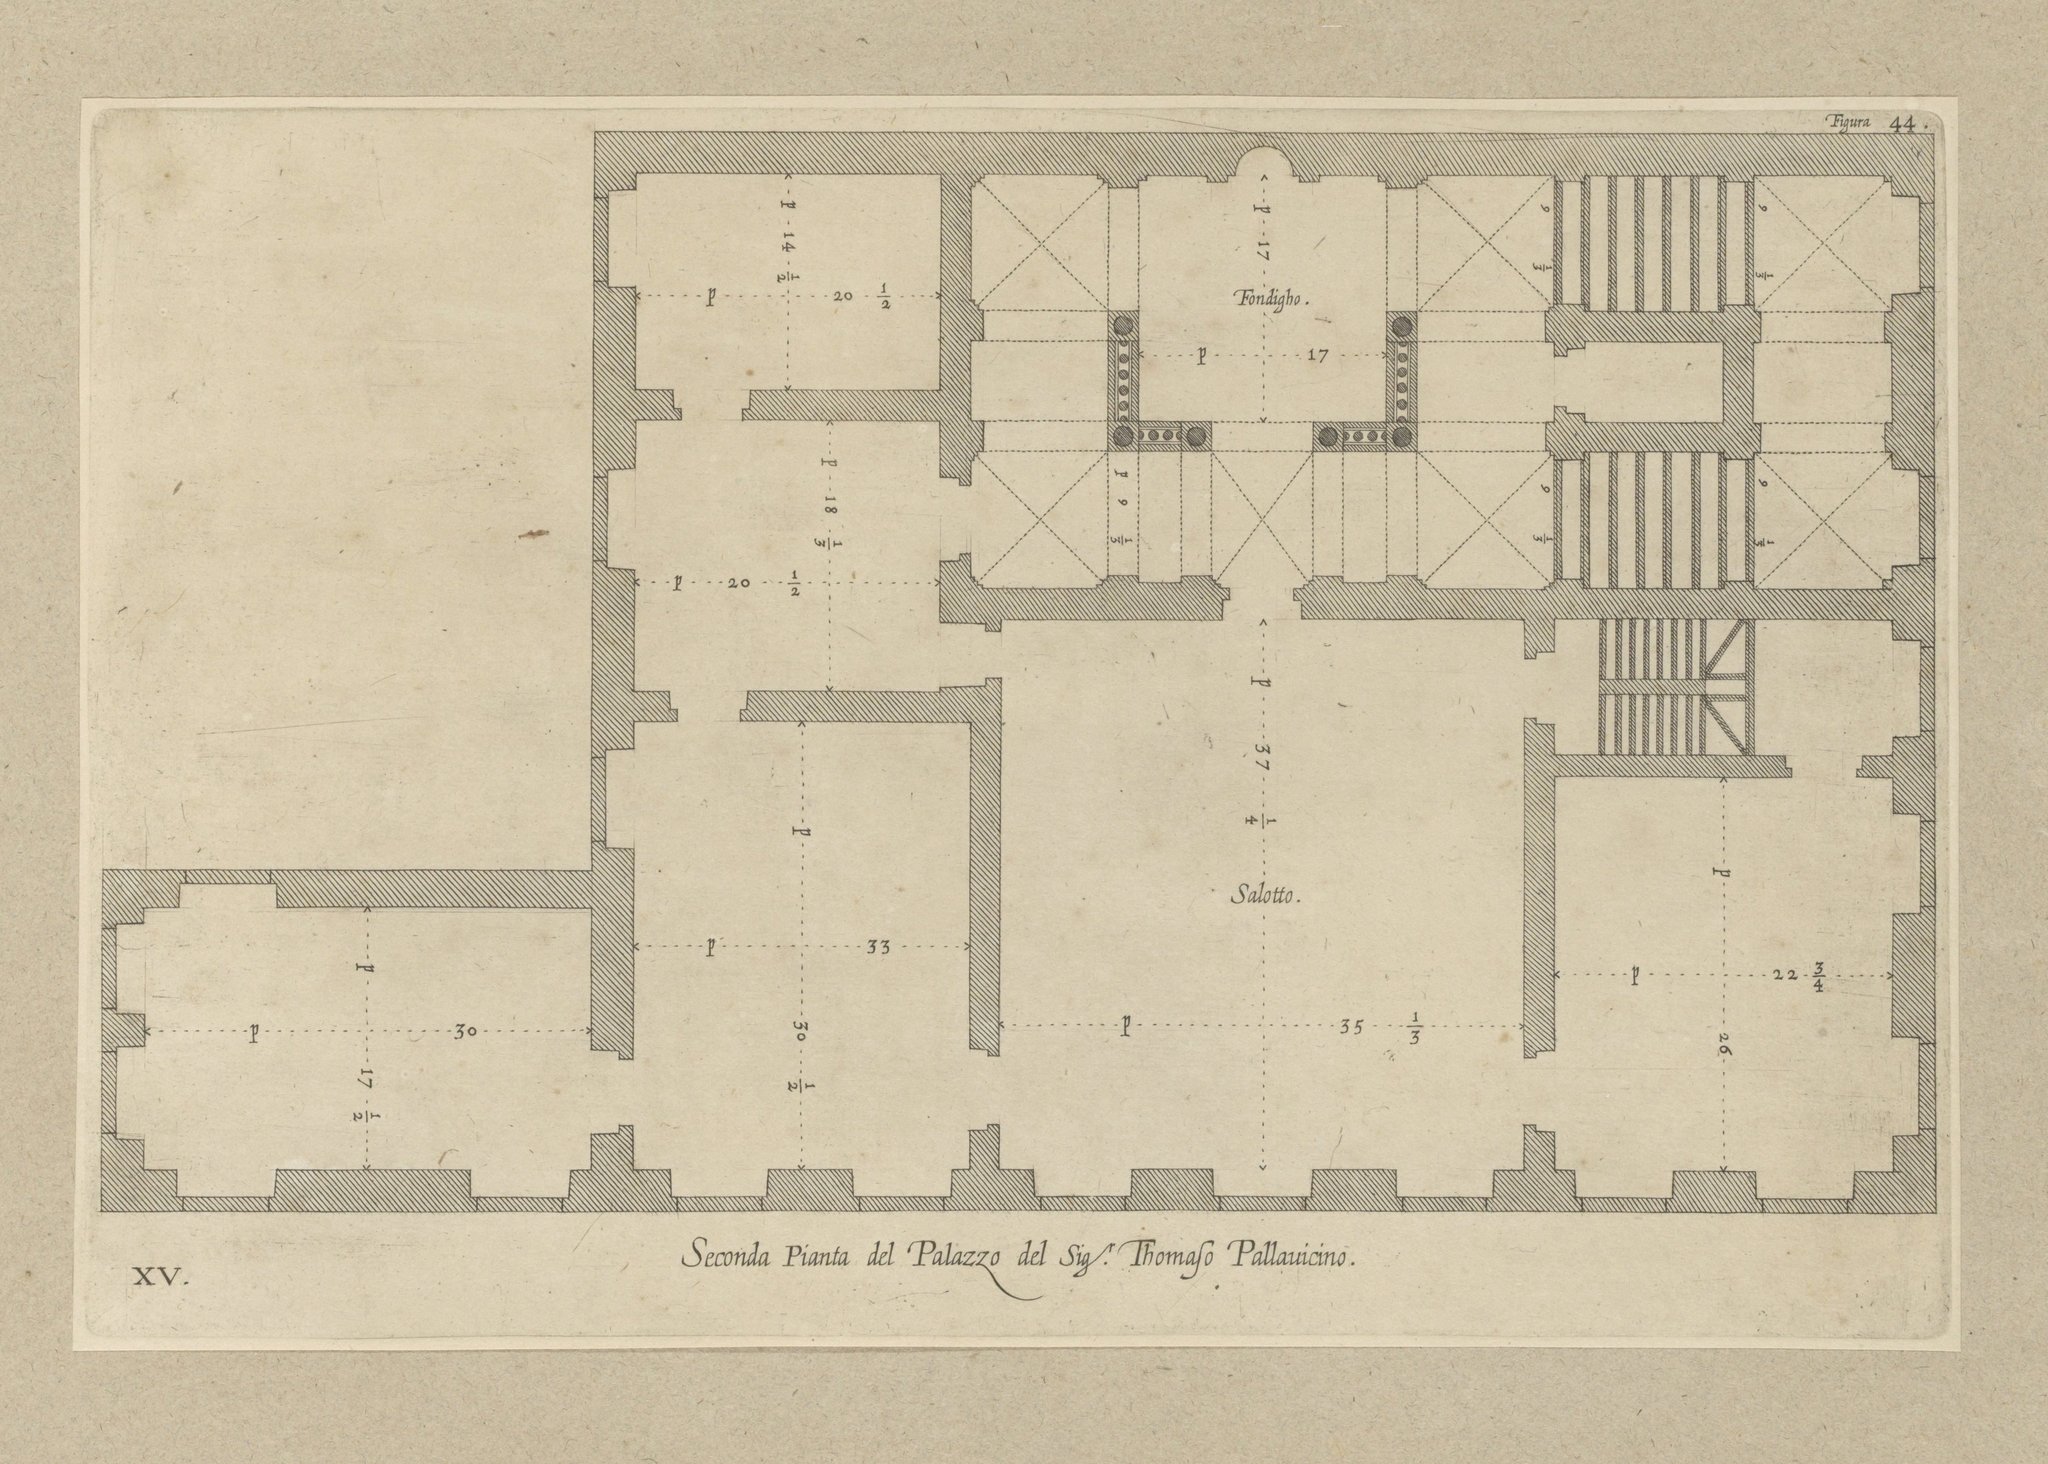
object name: print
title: Plattegrond van de eerste verdieping van het Palazzo dell'Acquedotto de Ferrari Galliera te Genua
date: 1622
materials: paper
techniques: engraving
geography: antwerp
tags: hôtel, i.e. small palace in city - aa - civic architecture: inside, plan ~ architecture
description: Deze prent maakt deel uit van een album.